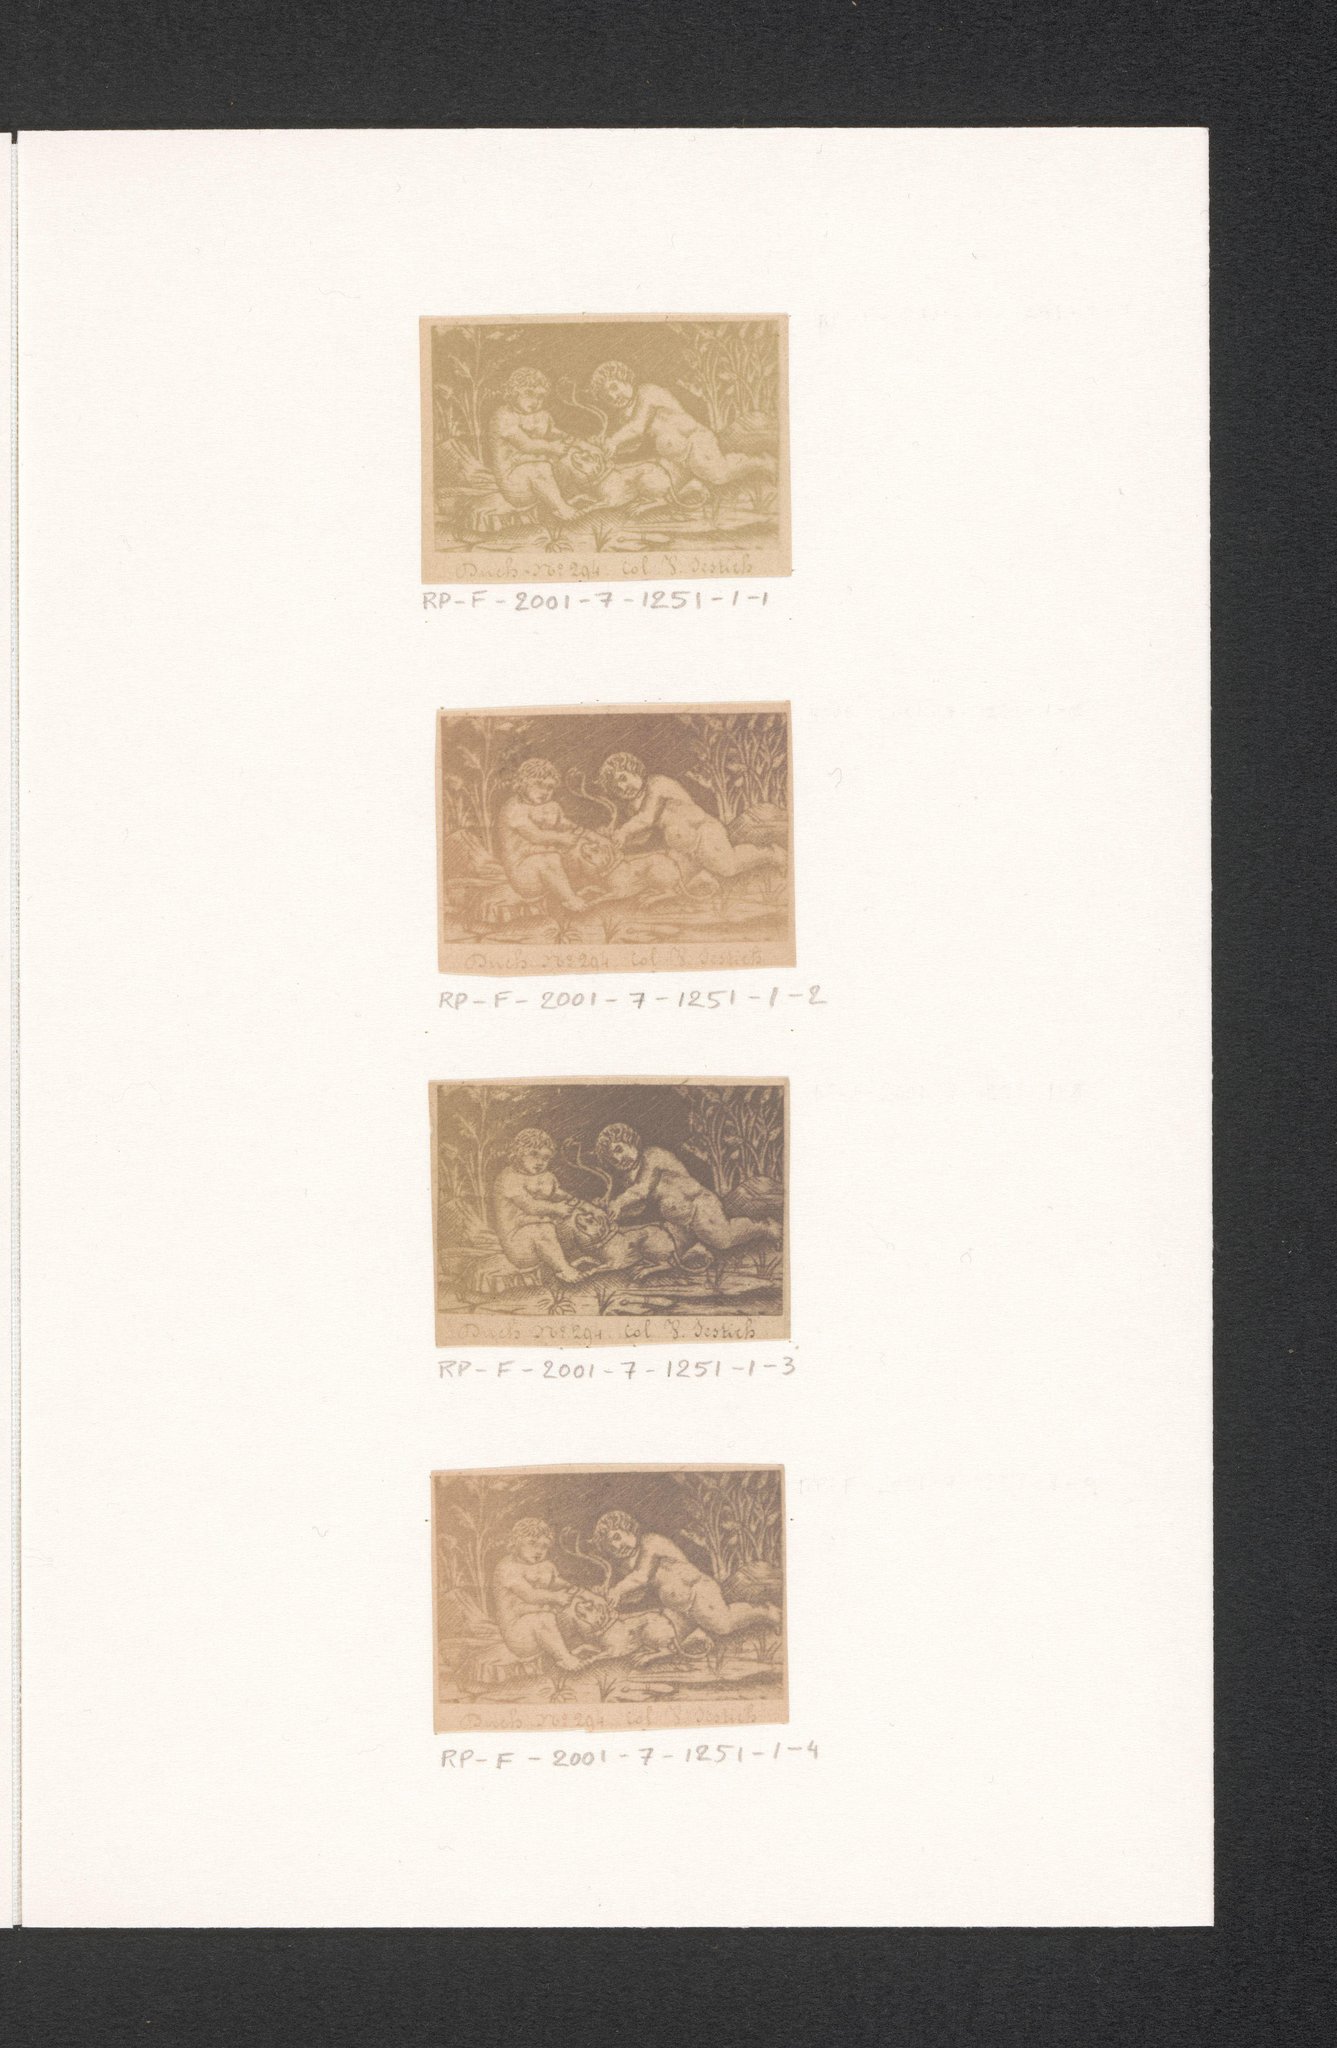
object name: reproduction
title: Fotoreproductie van een prent van twee kinderen die met een hond spelen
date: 1852-1857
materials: photographic support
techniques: salted paper print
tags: child, dog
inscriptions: inscription: ‘Duch. No 294. Col. V. Sestich’